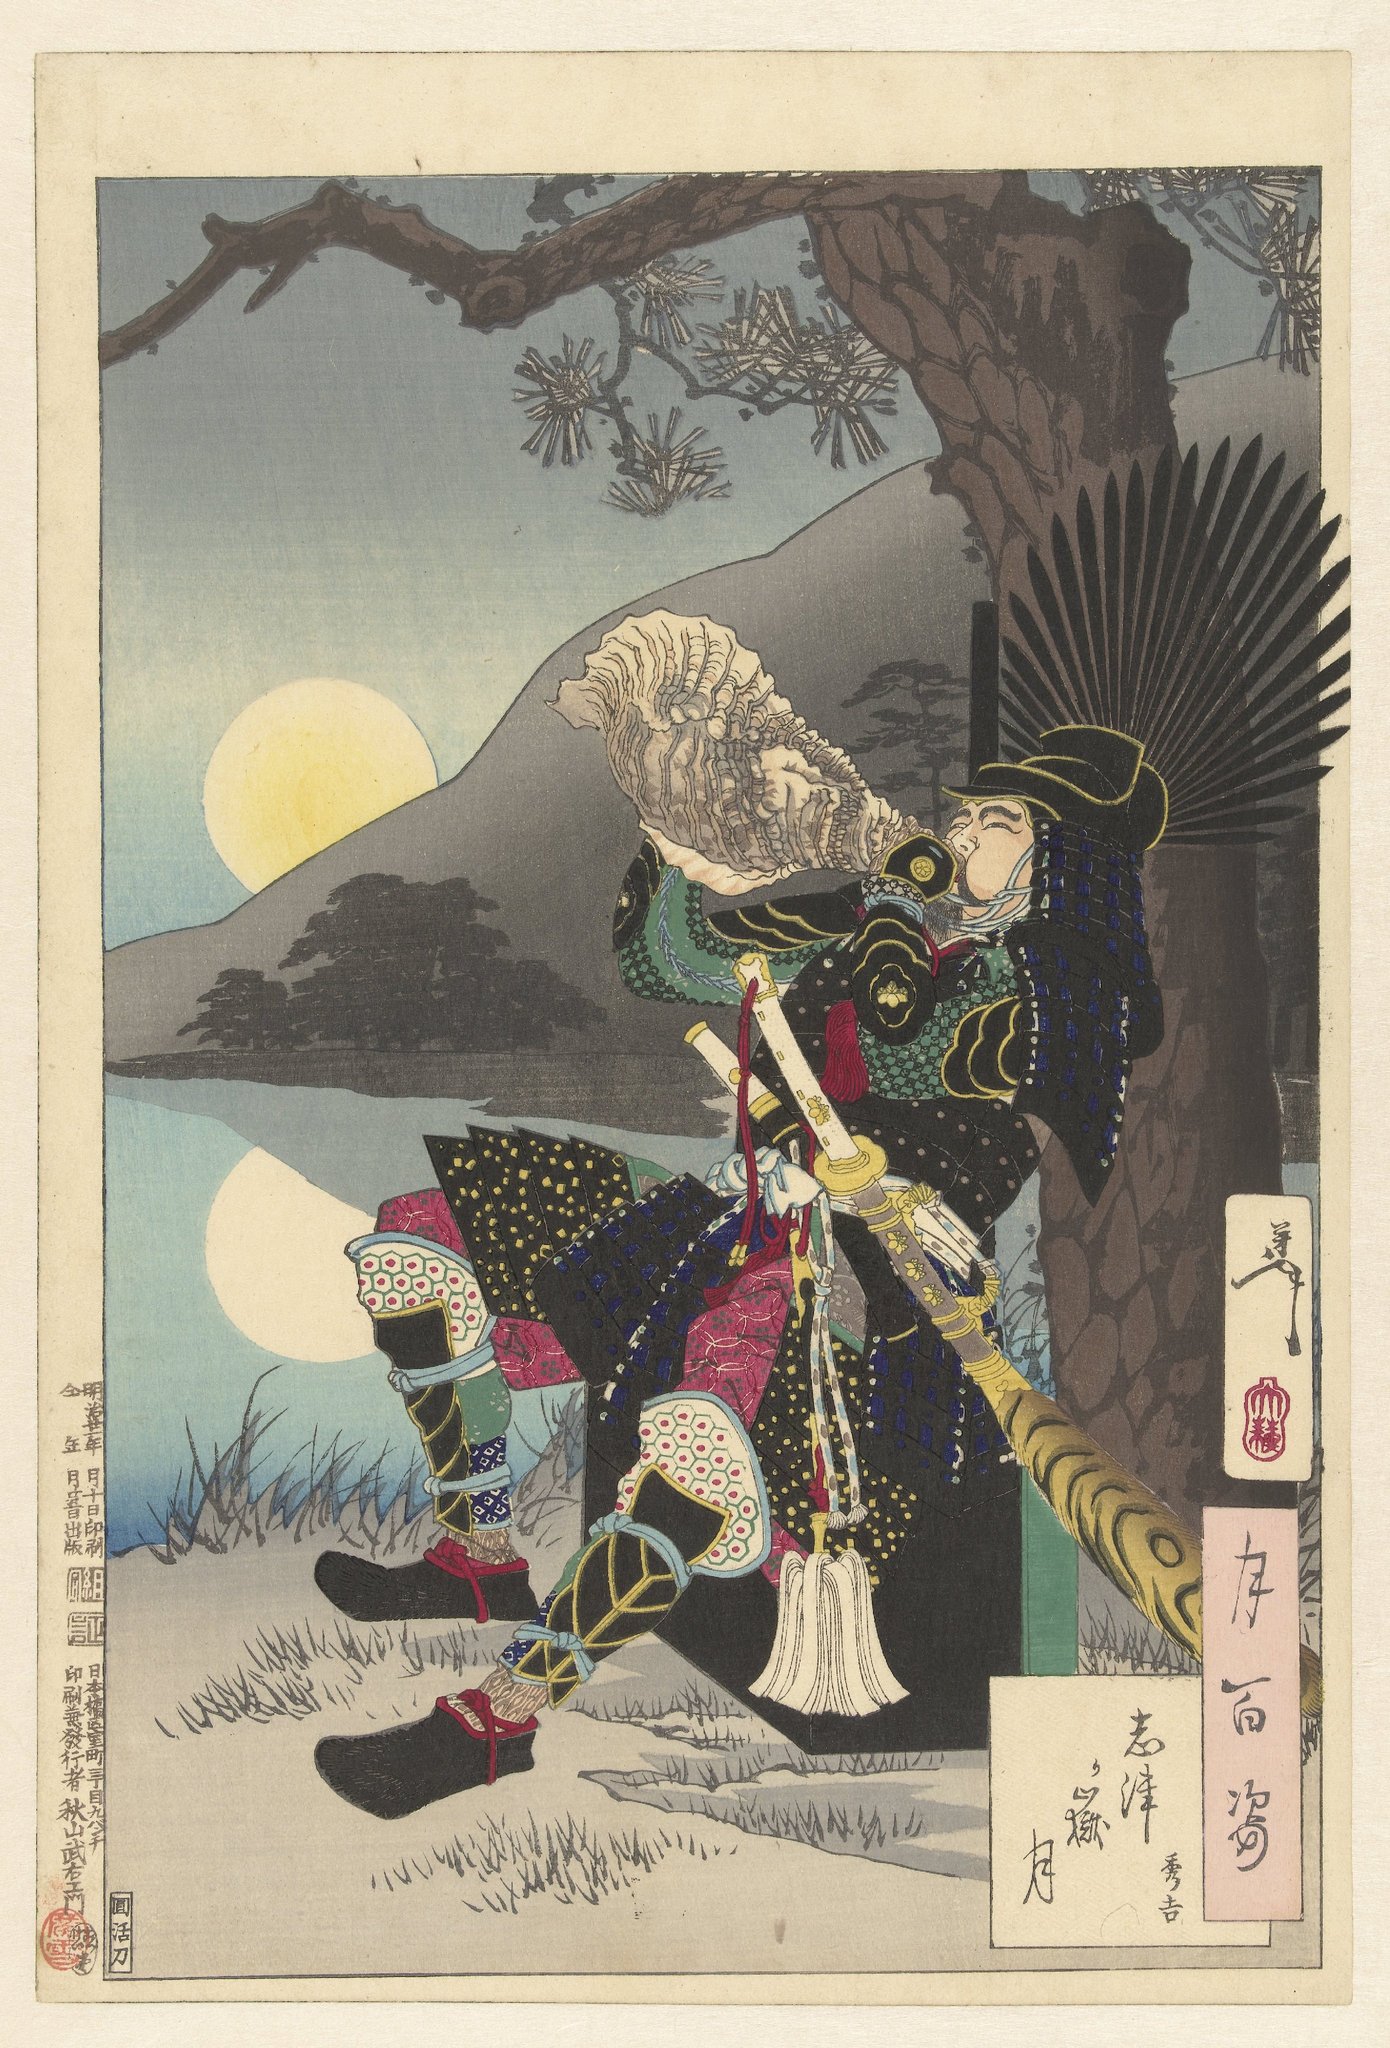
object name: print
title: Hideyoshi en de maan te Shizugatake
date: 1888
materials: paper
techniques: blind stamped, woodcut, polish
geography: tokyo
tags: armour, horn, trumpet, cornet, trombone, tuba - cc - out of doors, water course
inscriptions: collector's mark: Lugt 2228, collector's mark: Lugt 2760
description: Toyotomi Hideyoshi in harnas zittend onder pijnboom, blazend op grote schelp om aan zijn leger de aanval aan te kondigende; bij ochtendgloren met een achter de bergen verdwijnende maan, weerspiegeld in het water.